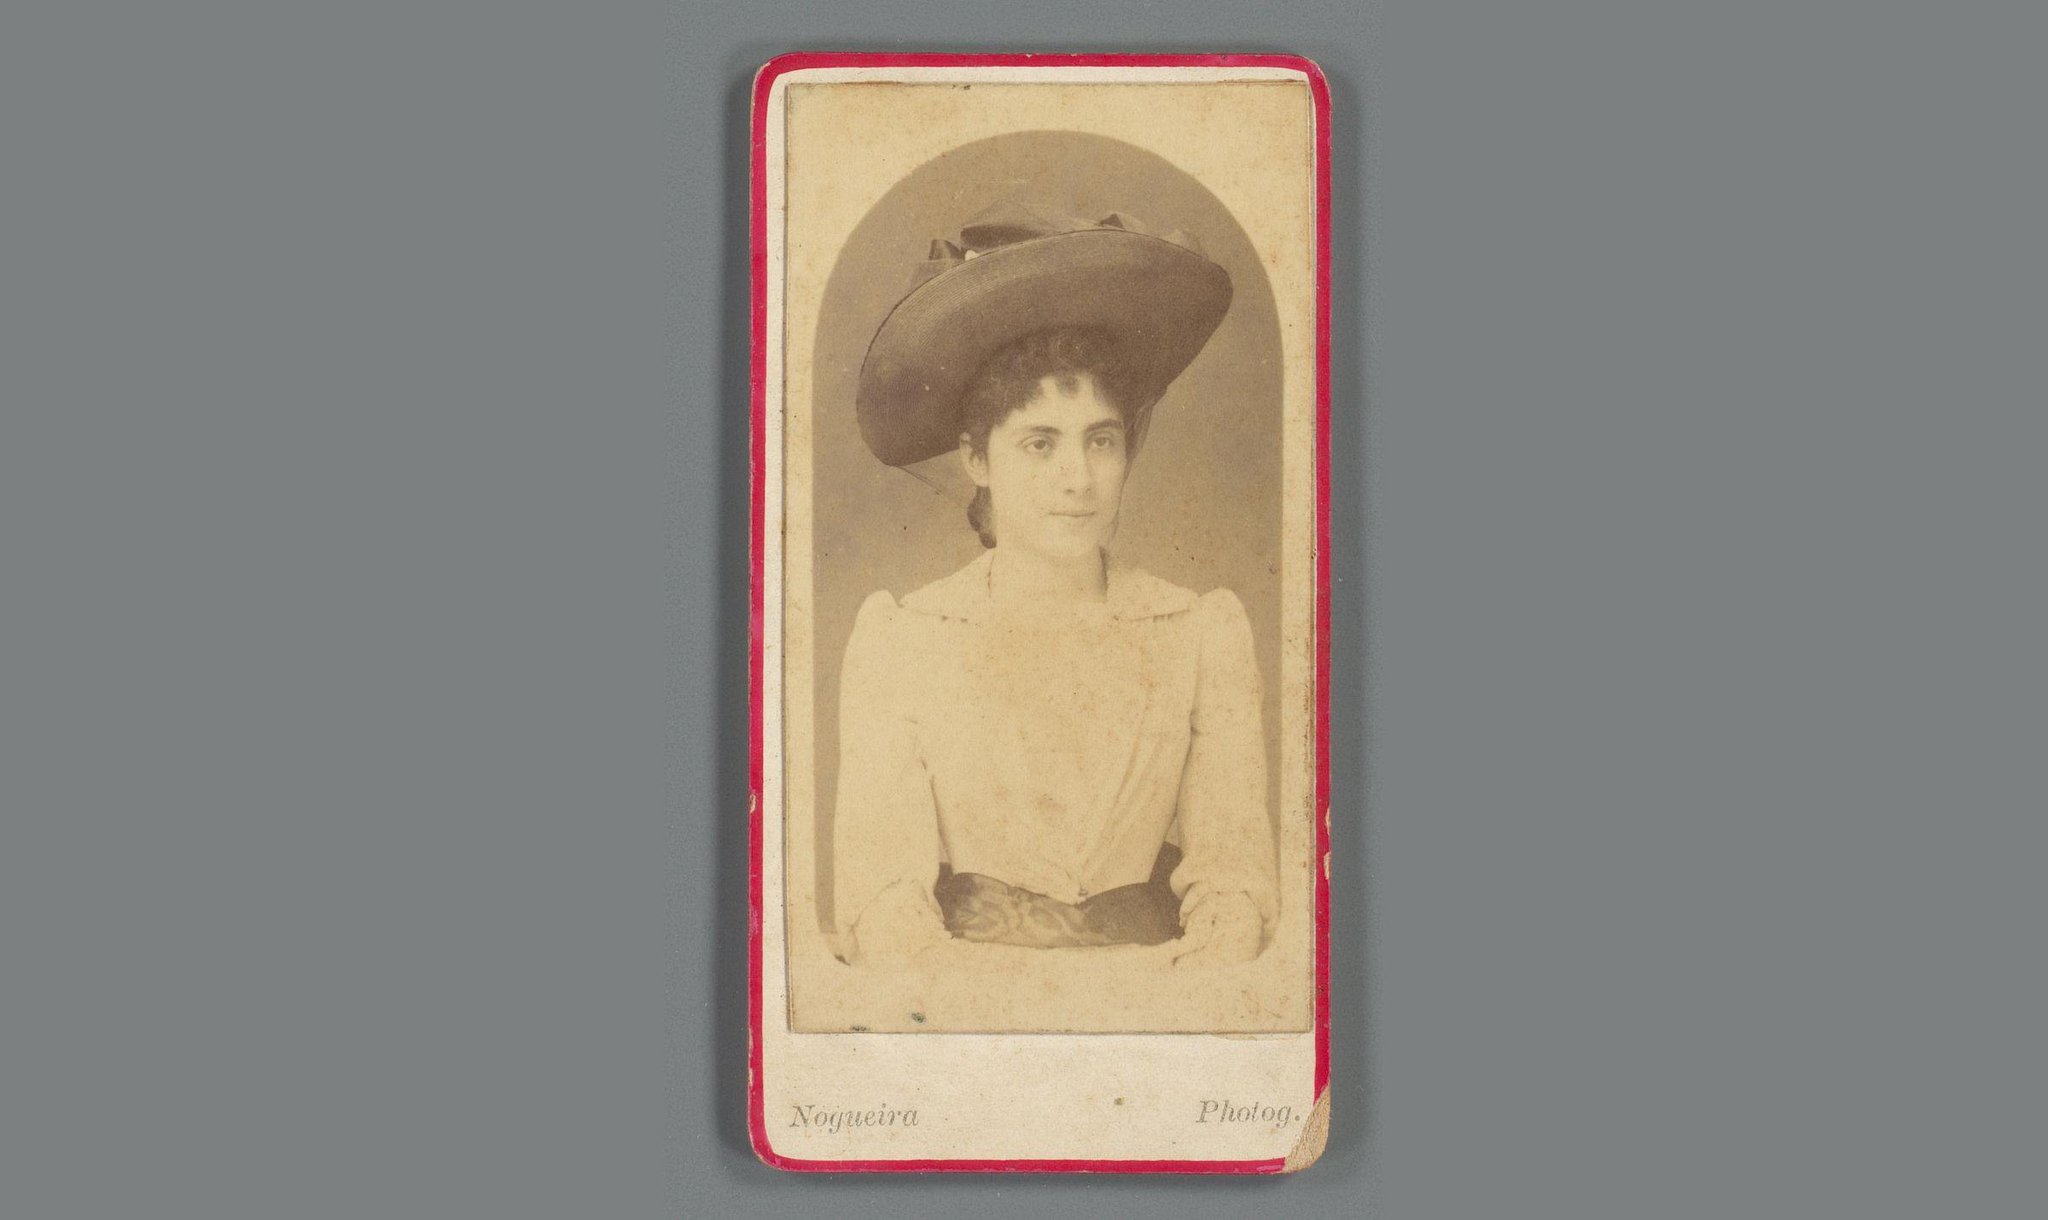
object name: photograph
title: Miniatuurportret van een onbekende vrouw met hoed en voile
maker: manoel a. silva nogueira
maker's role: fotograaf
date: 1890-1910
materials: cardboard, paper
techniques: albumen print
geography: santarém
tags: adult woman, historical persons not known by name - bb - woman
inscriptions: inscription: ‘Nogueira Photog.’, inscription: ‘Photographia/ Artistica/ de/ M.A.S. Nogueira/ Valle de/ Santarem’